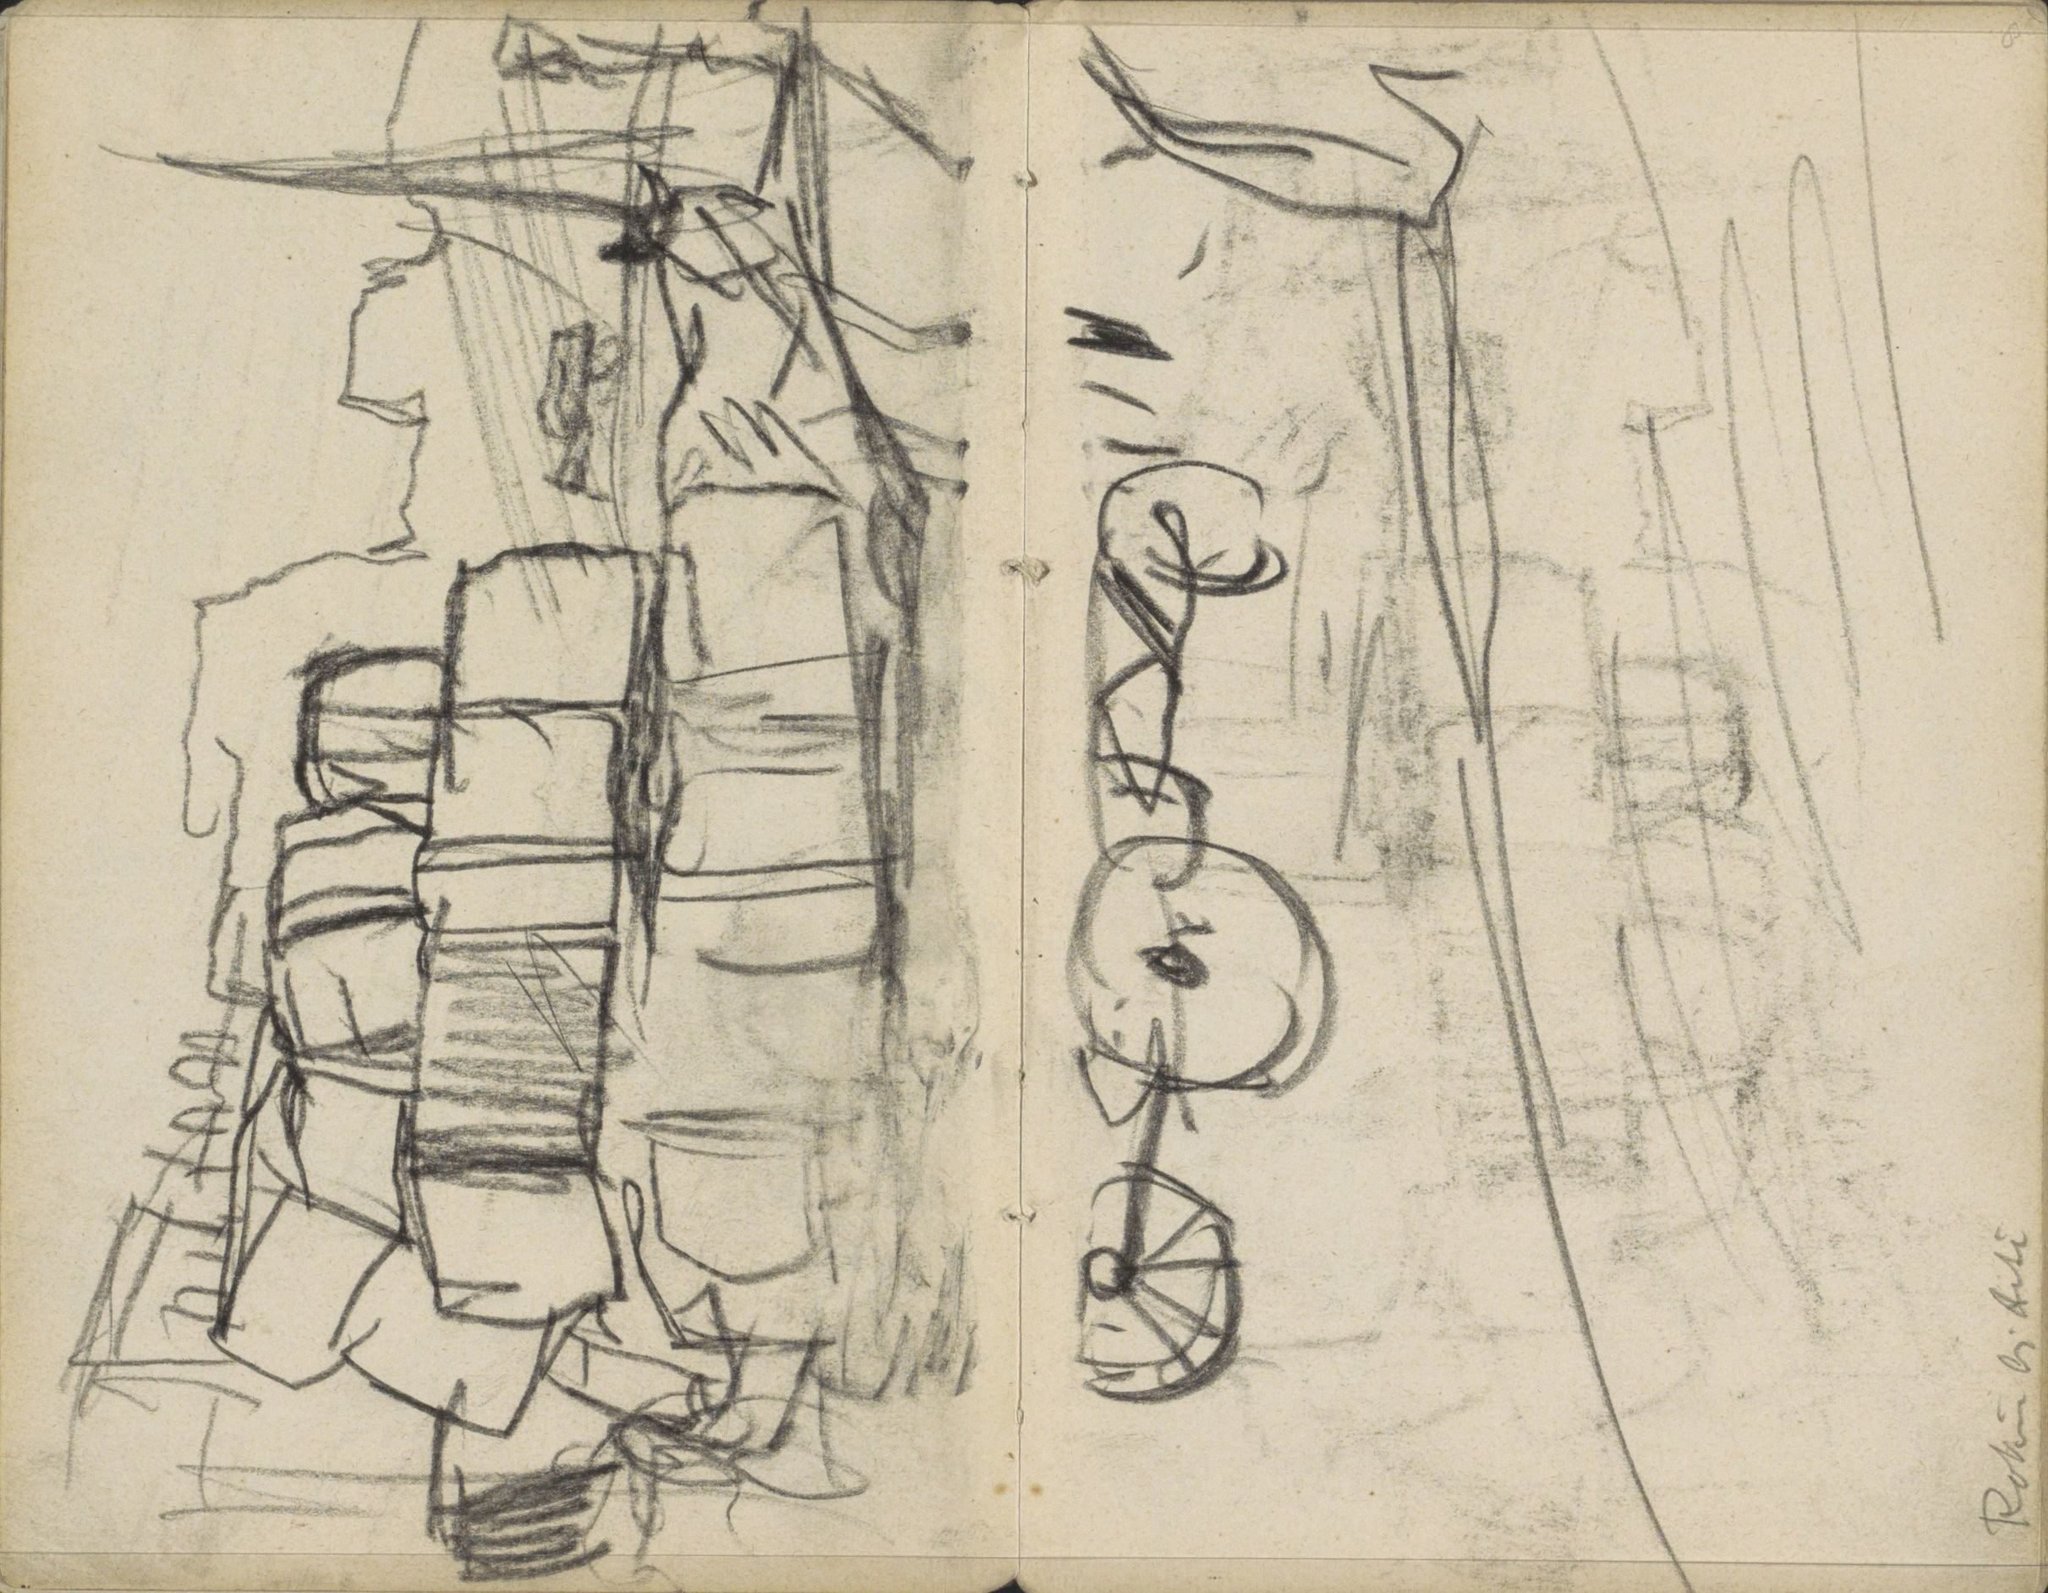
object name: sketchbook leaf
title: Gezicht op het Rokin te Amsterdam met een paard-en-wagen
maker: george hendrik breitner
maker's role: draughtsman, painter, print maker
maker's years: 1857-1923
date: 1902-1903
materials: chalk, paper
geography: amsterdam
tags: four-wheeled vehicle drawn by one animal, urban housing, horse, street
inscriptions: annotation: ‘Rokin bij Arti’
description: Gezicht op het Rokin te Amsterdam ter hoogte van nummer 112, Arti et Amicitiae. Vooraan een paard-en-wagen. Pagina 7 en pagina 8 uit een schetsboek met 46 bladen vervaardigd te Noord-Holland en Utrecht.